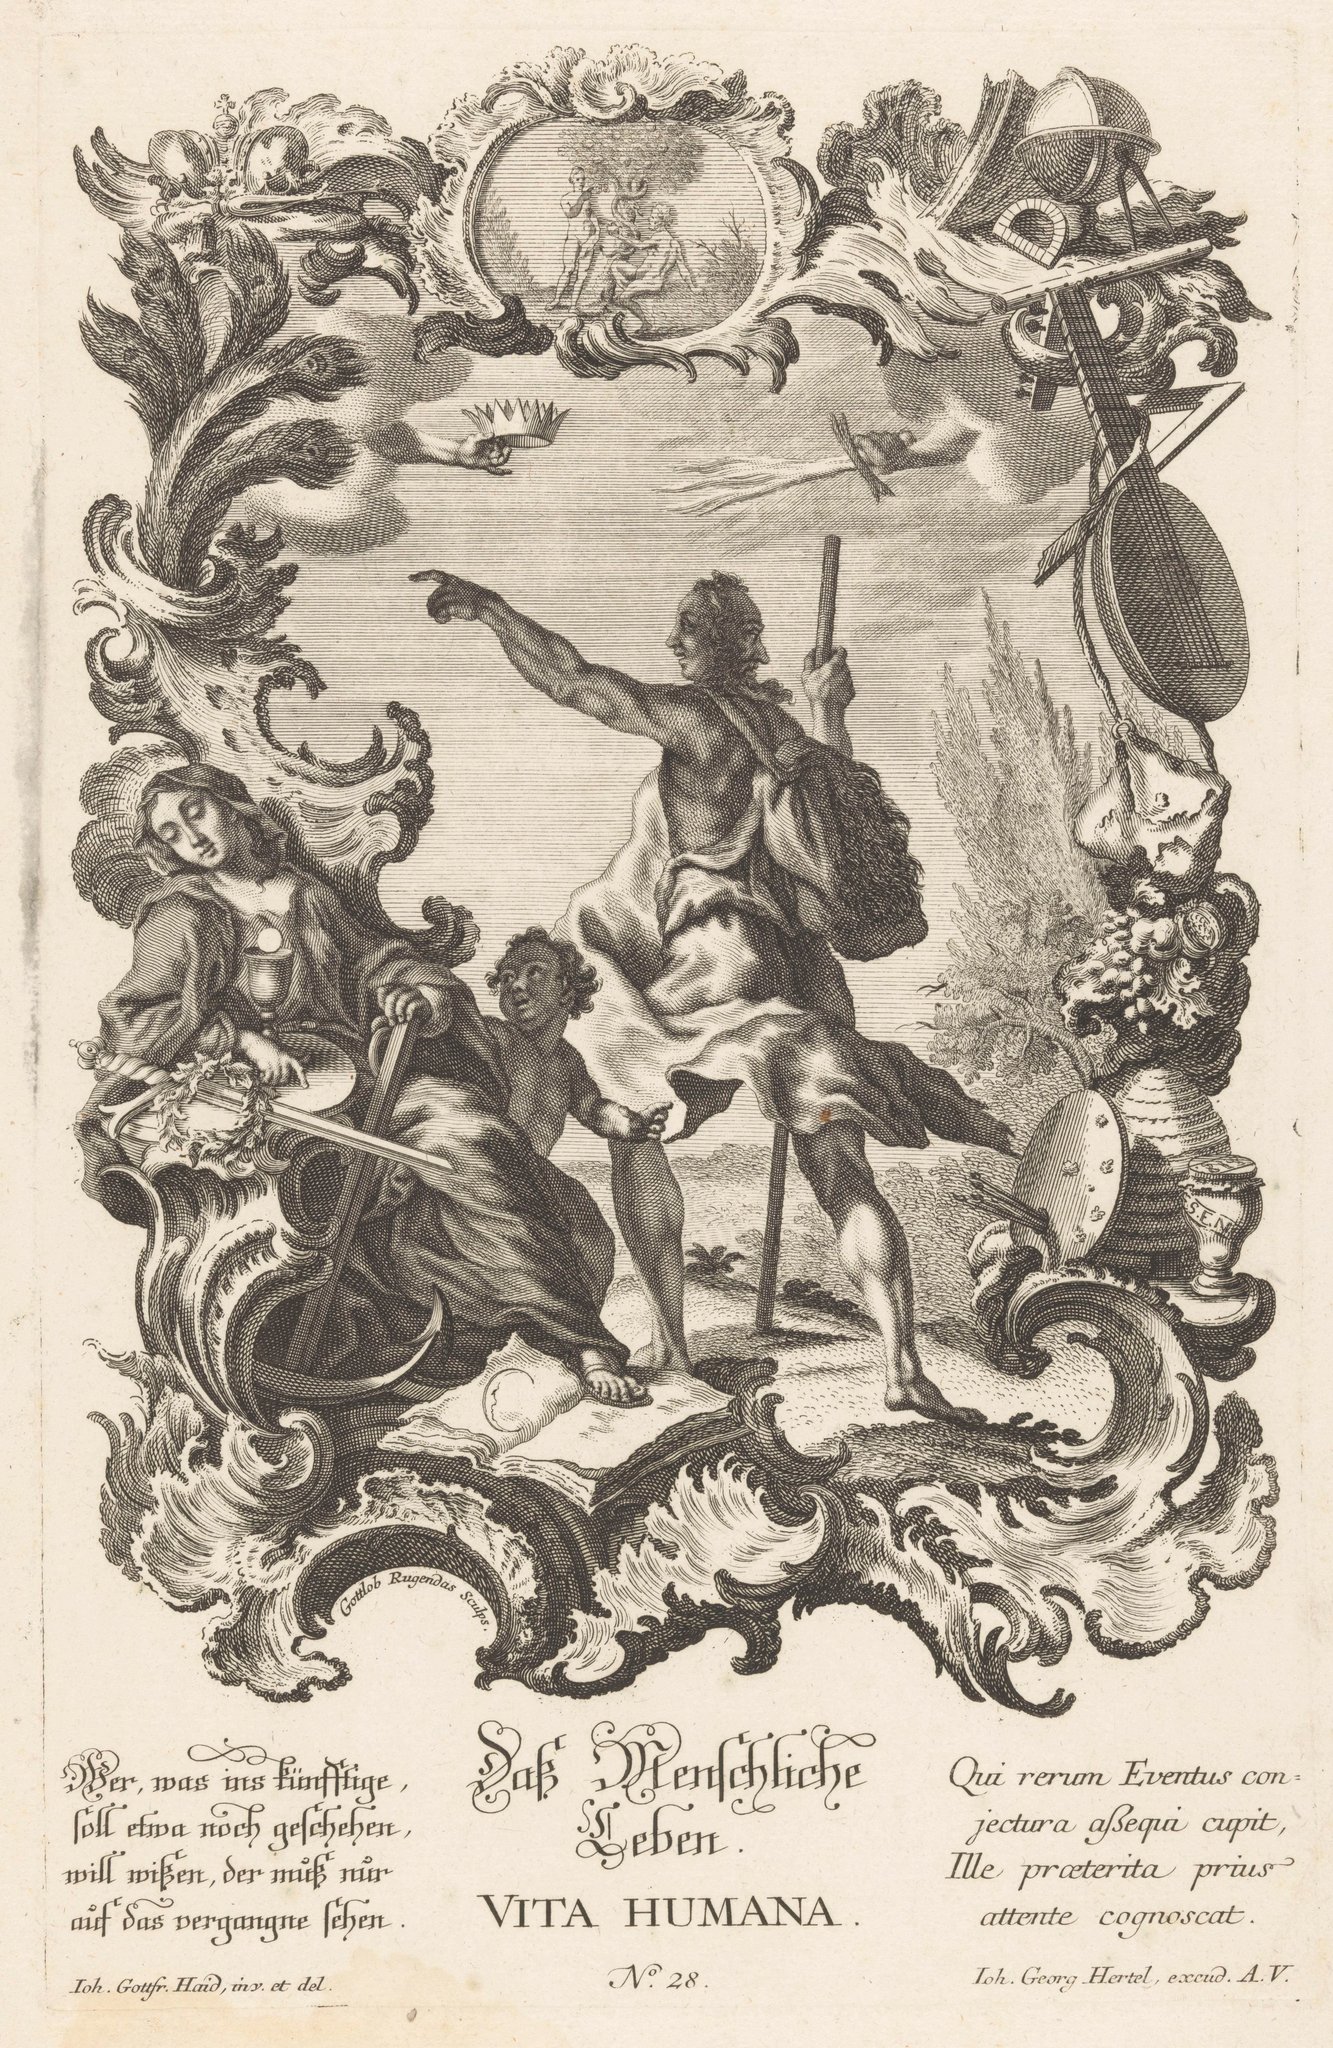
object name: ornament print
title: Daß Menschliche Leben/ Vita Humana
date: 1745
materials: paper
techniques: etching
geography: augsburg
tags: human life; 'vita humana', 'vita inquieta', 'vita e l'animo' (ripa), (story of) janus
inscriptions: collector's mark: Lugt 2228, collector's mark: Lugt 2760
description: Allegorie van het menselijk leven, omgeven door rocaille omlijsting. Links zit een vrouw met een kelk met hostie, een zwaard, een lauwerkrans en een anker. Haar voet rust op een boek met afbeelding van de maan. In het landschap achter haar loopt een man met twee gezichten, de god Janus. In de ondermarge tweemaal een vierregelige Duits en Latijnse tekst. Uitgeversnummer 28.